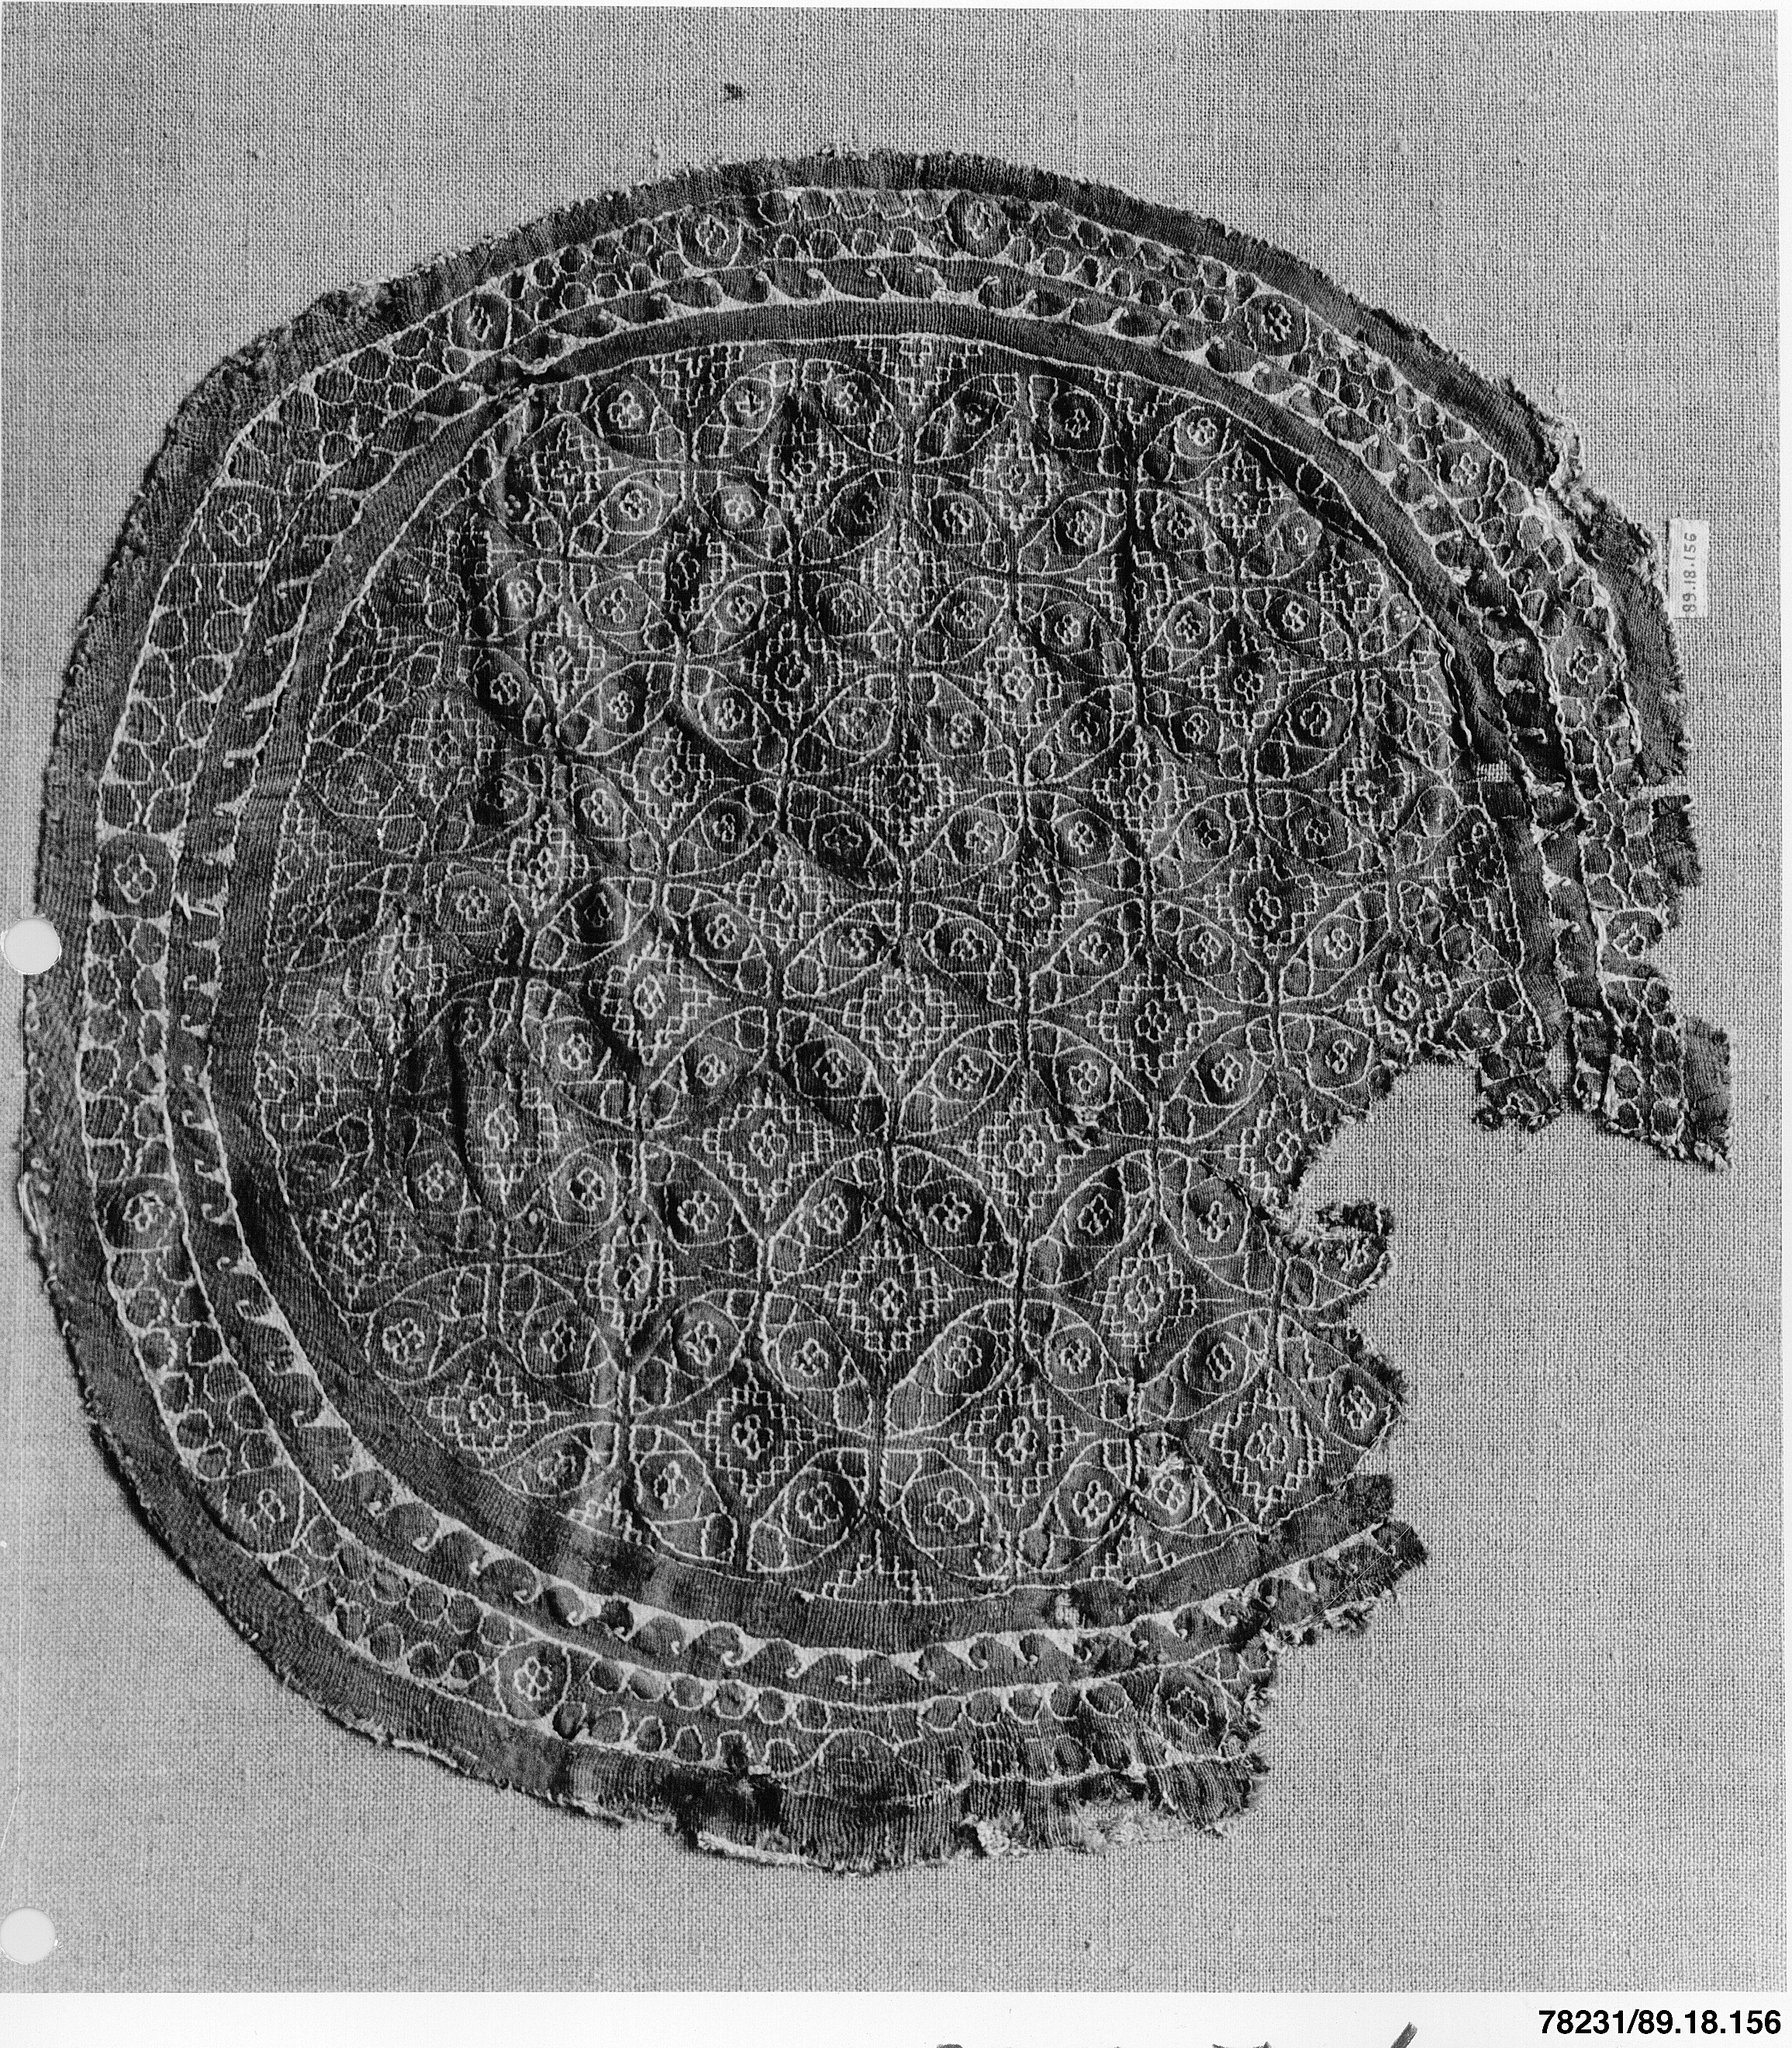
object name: textile fragment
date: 201-400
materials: linen, wool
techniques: weave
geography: egypt